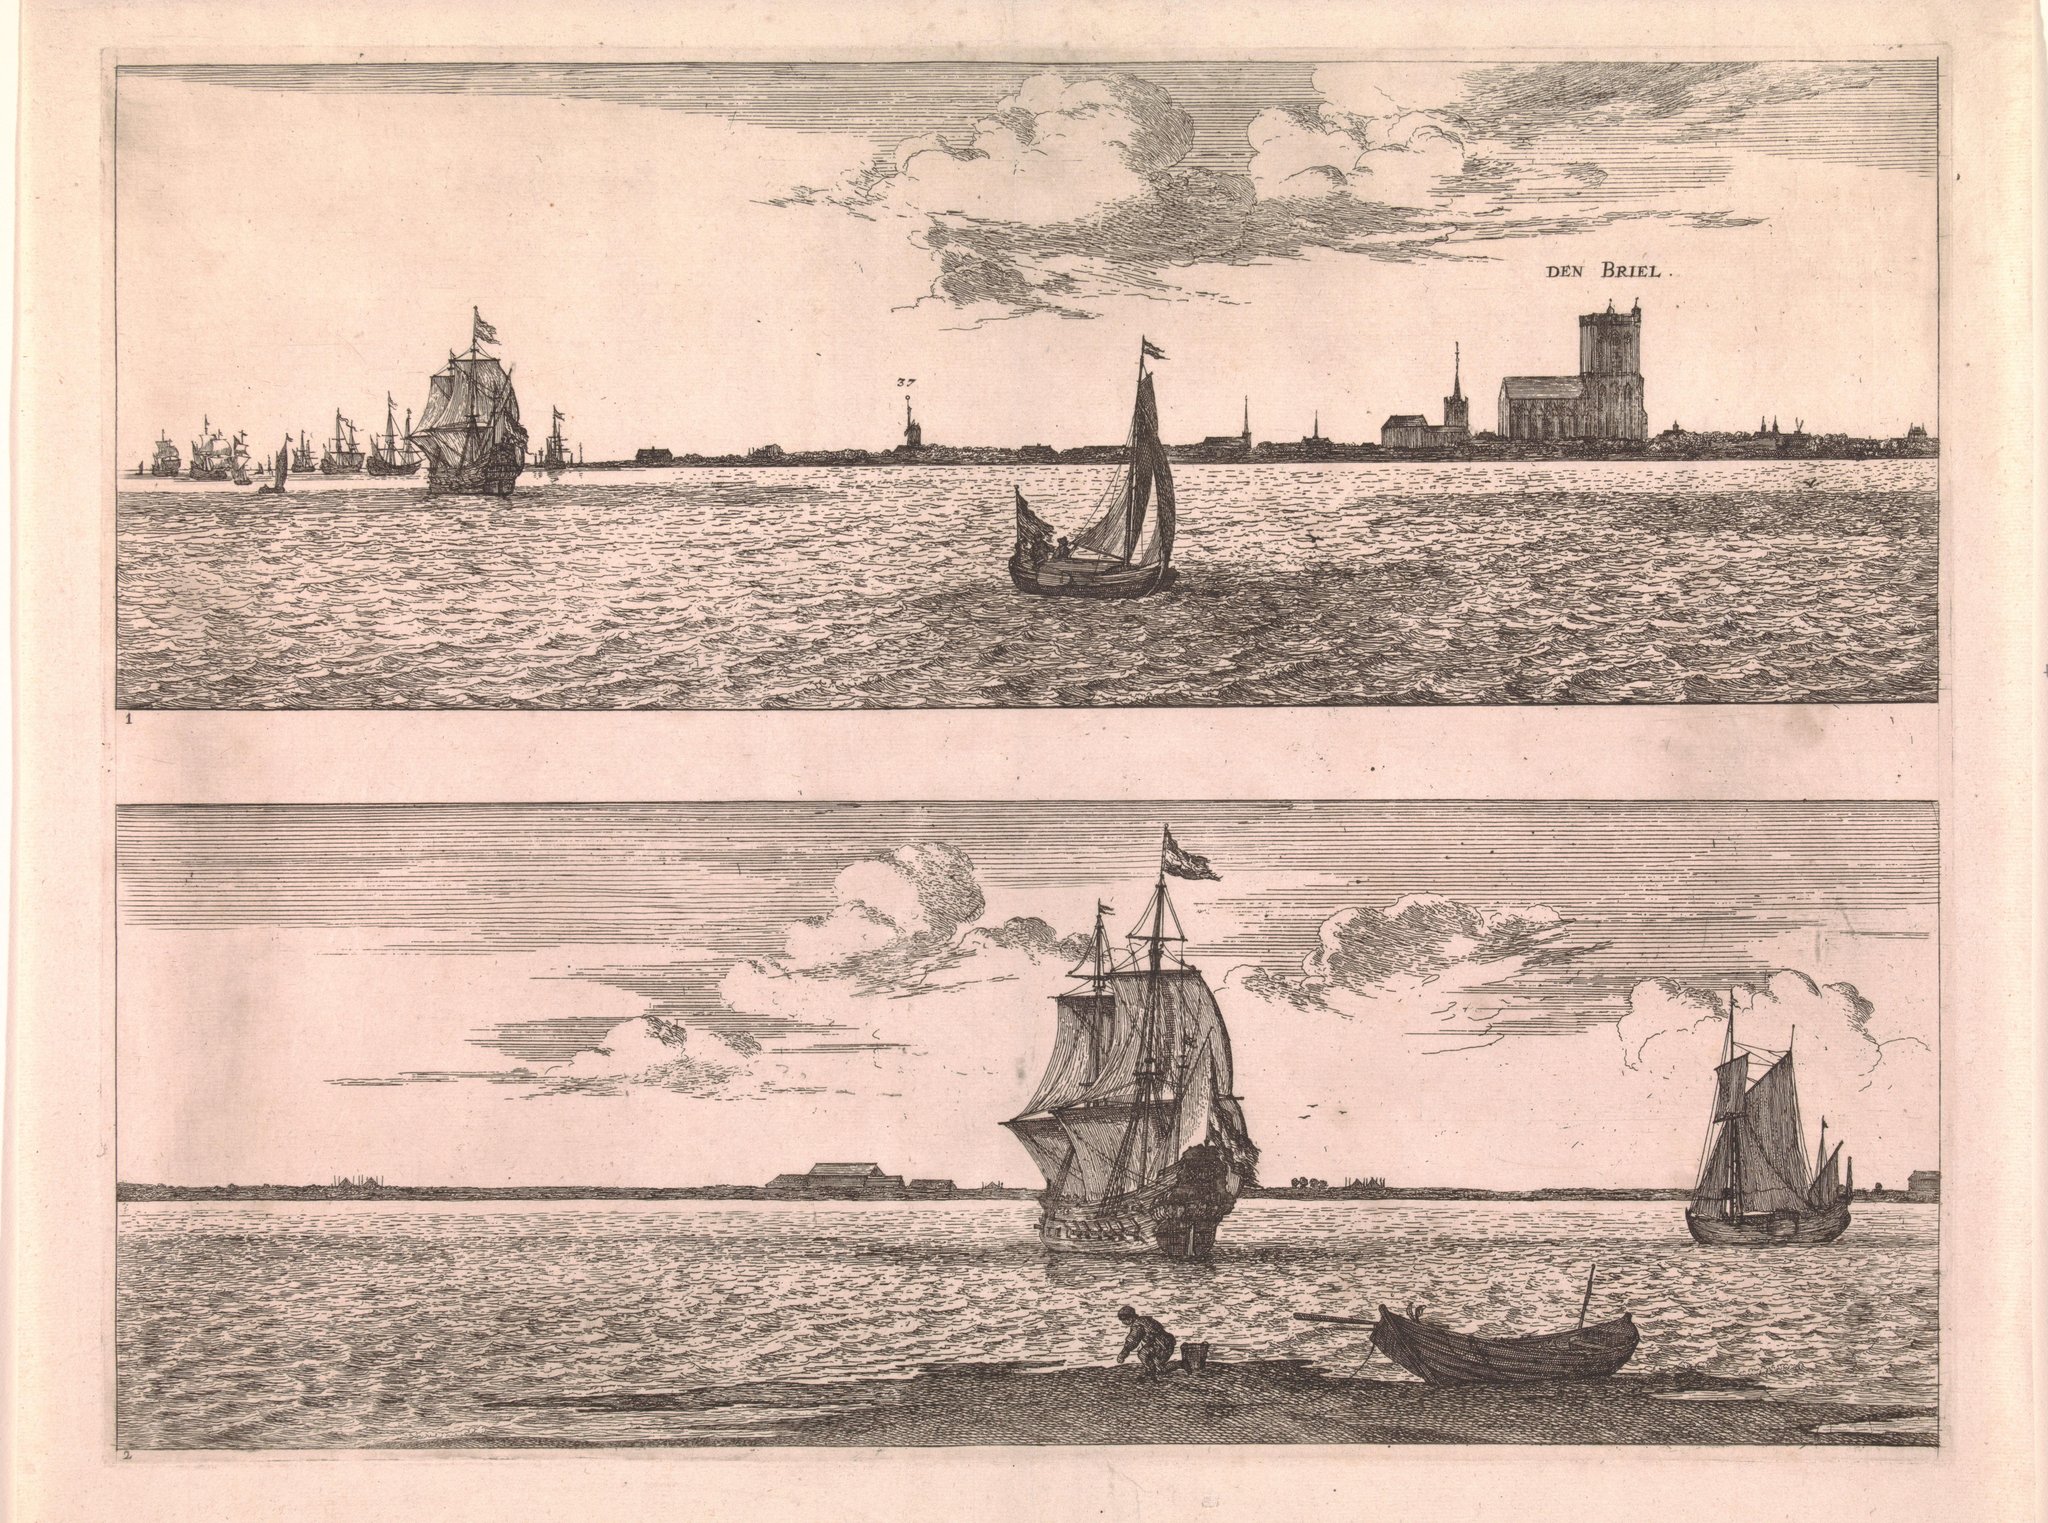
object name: print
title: Gezicht op Brielle / Gezicht op de Maas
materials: paper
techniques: engraving, etching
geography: rotterdam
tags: city-view in general; 'veduta', river, brielle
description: Gezicht op de westkant van de Maas met op de achtergrond de stad Brielle (Den Briel), genummerd 1. Daaronder Gezicht op de westkant van de Maas, genummerd 2.